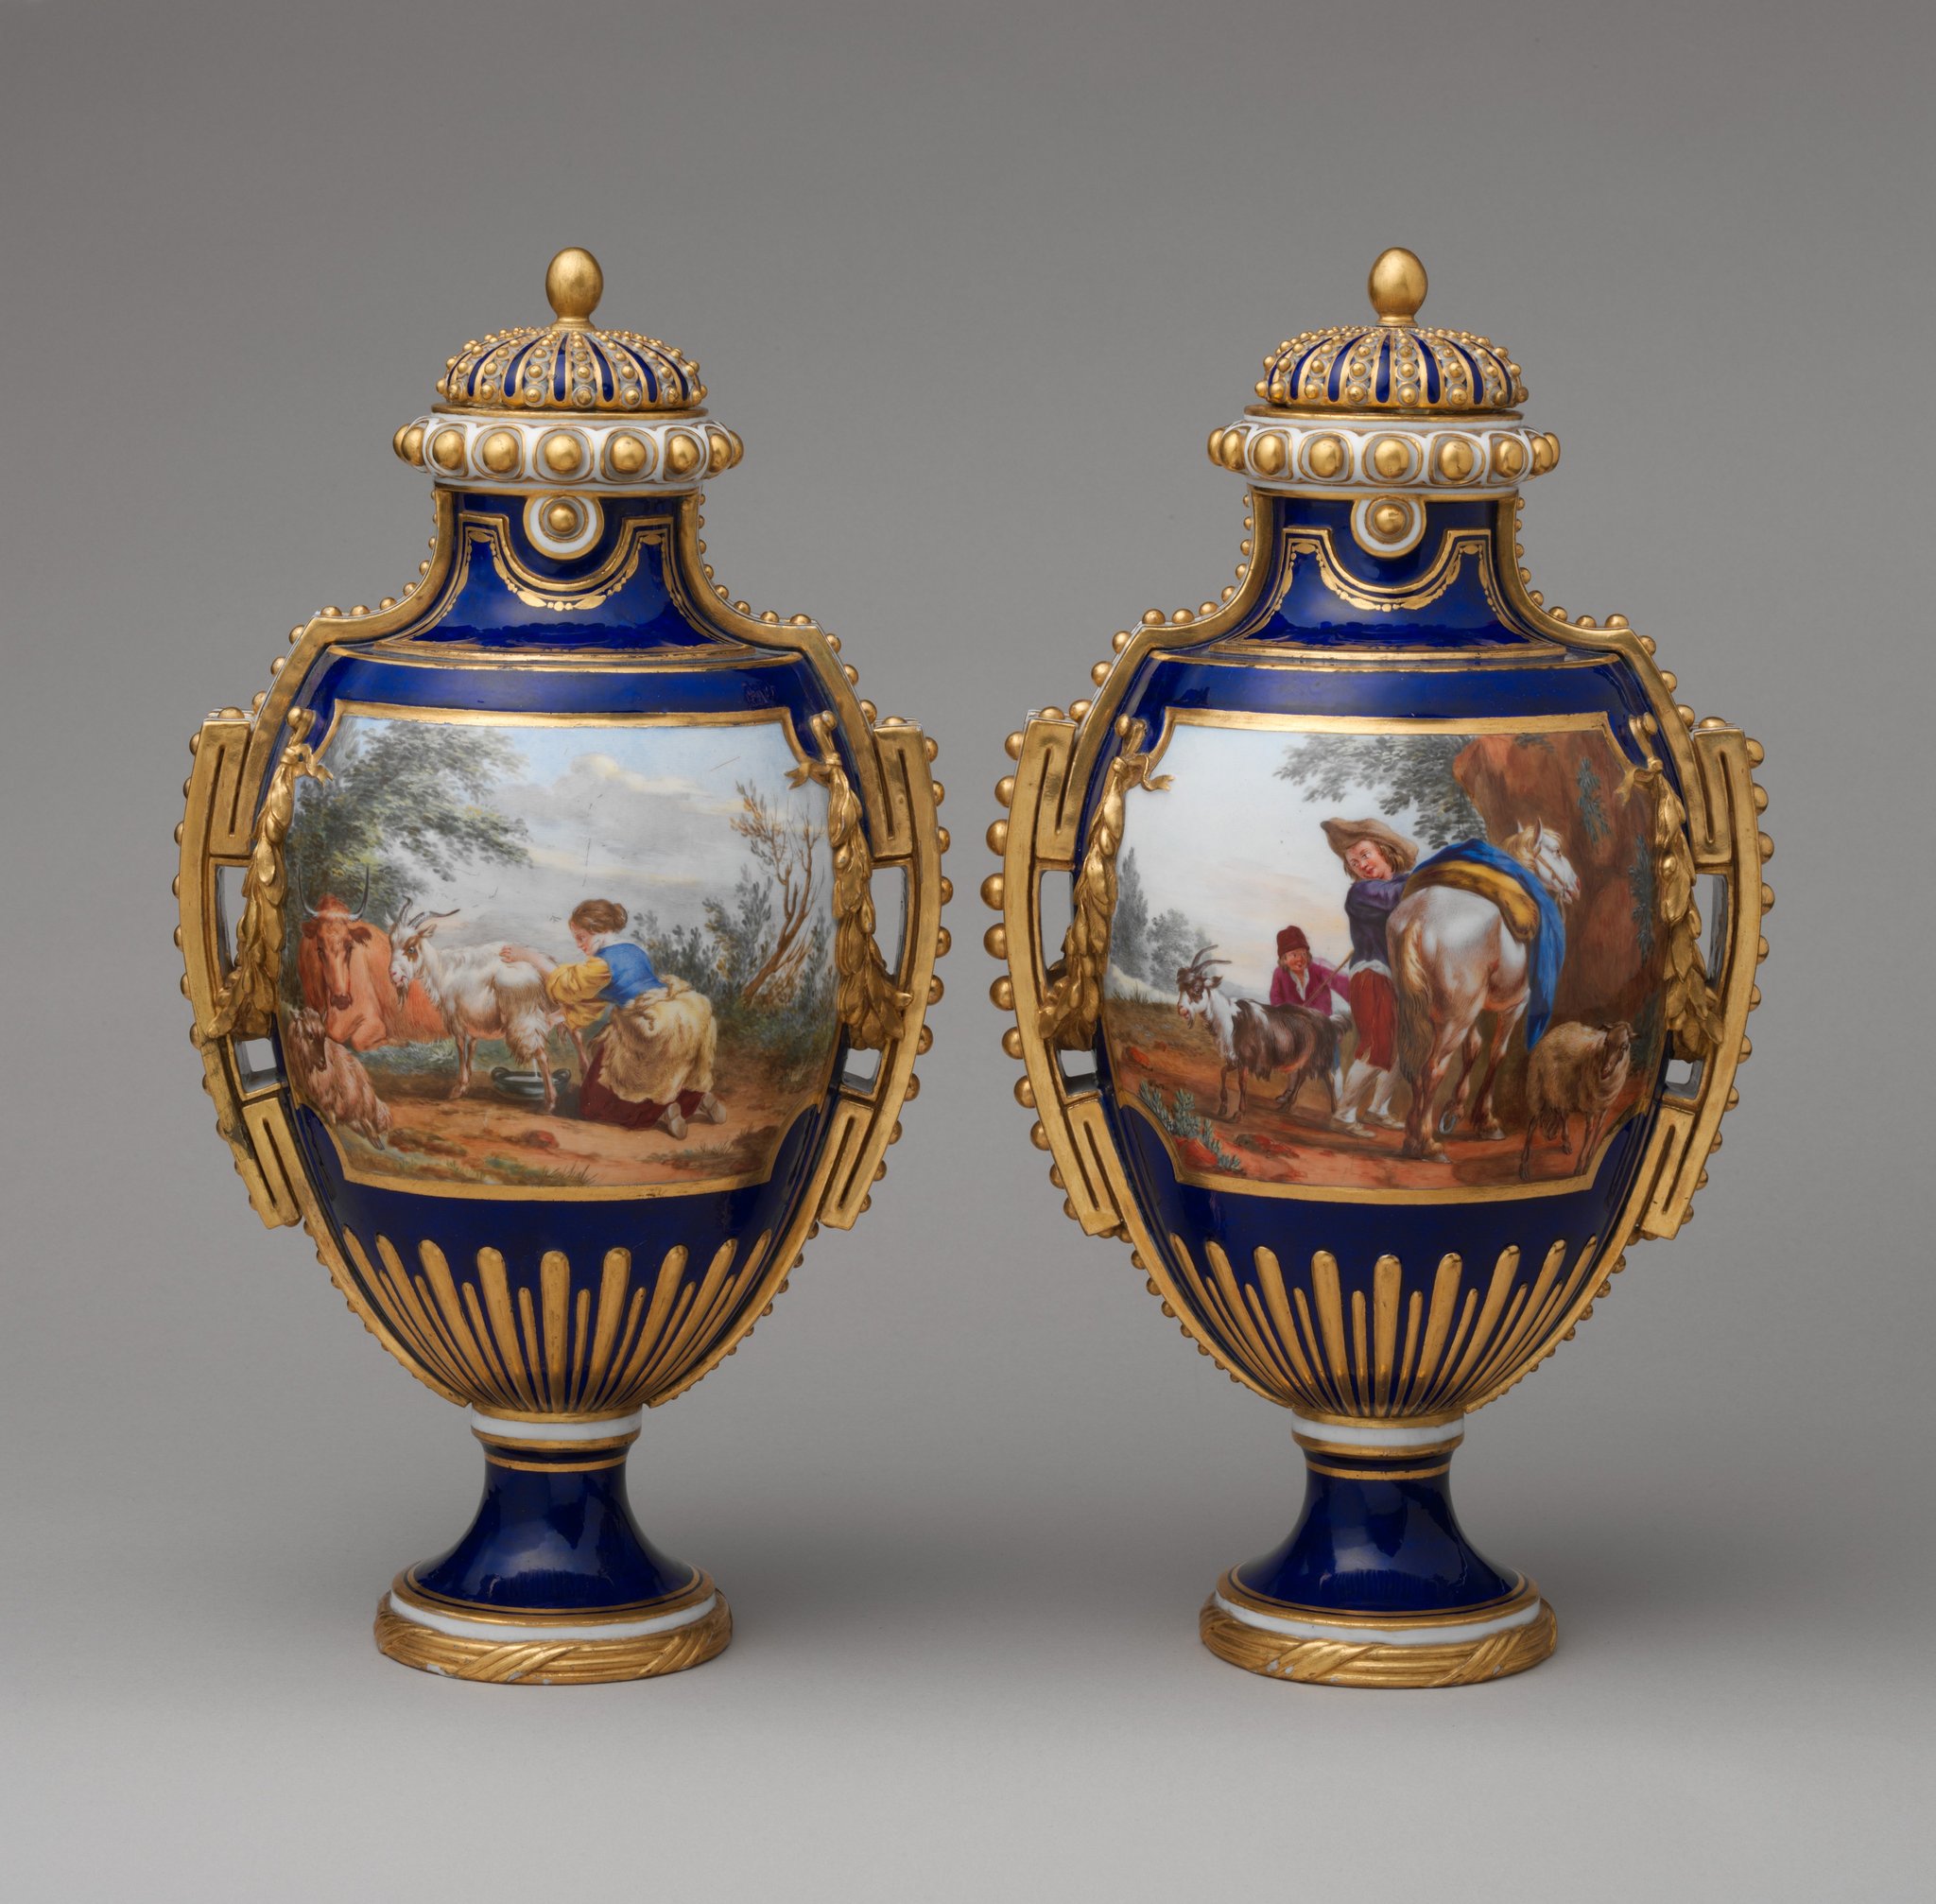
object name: vase with cover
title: Vase with cover (vase à panneaux or à perles) (one of a pair)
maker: sèvres manufactory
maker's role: manufactory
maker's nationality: french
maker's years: 1740-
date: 1766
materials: soft paste porcelain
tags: animals,boys,men,women